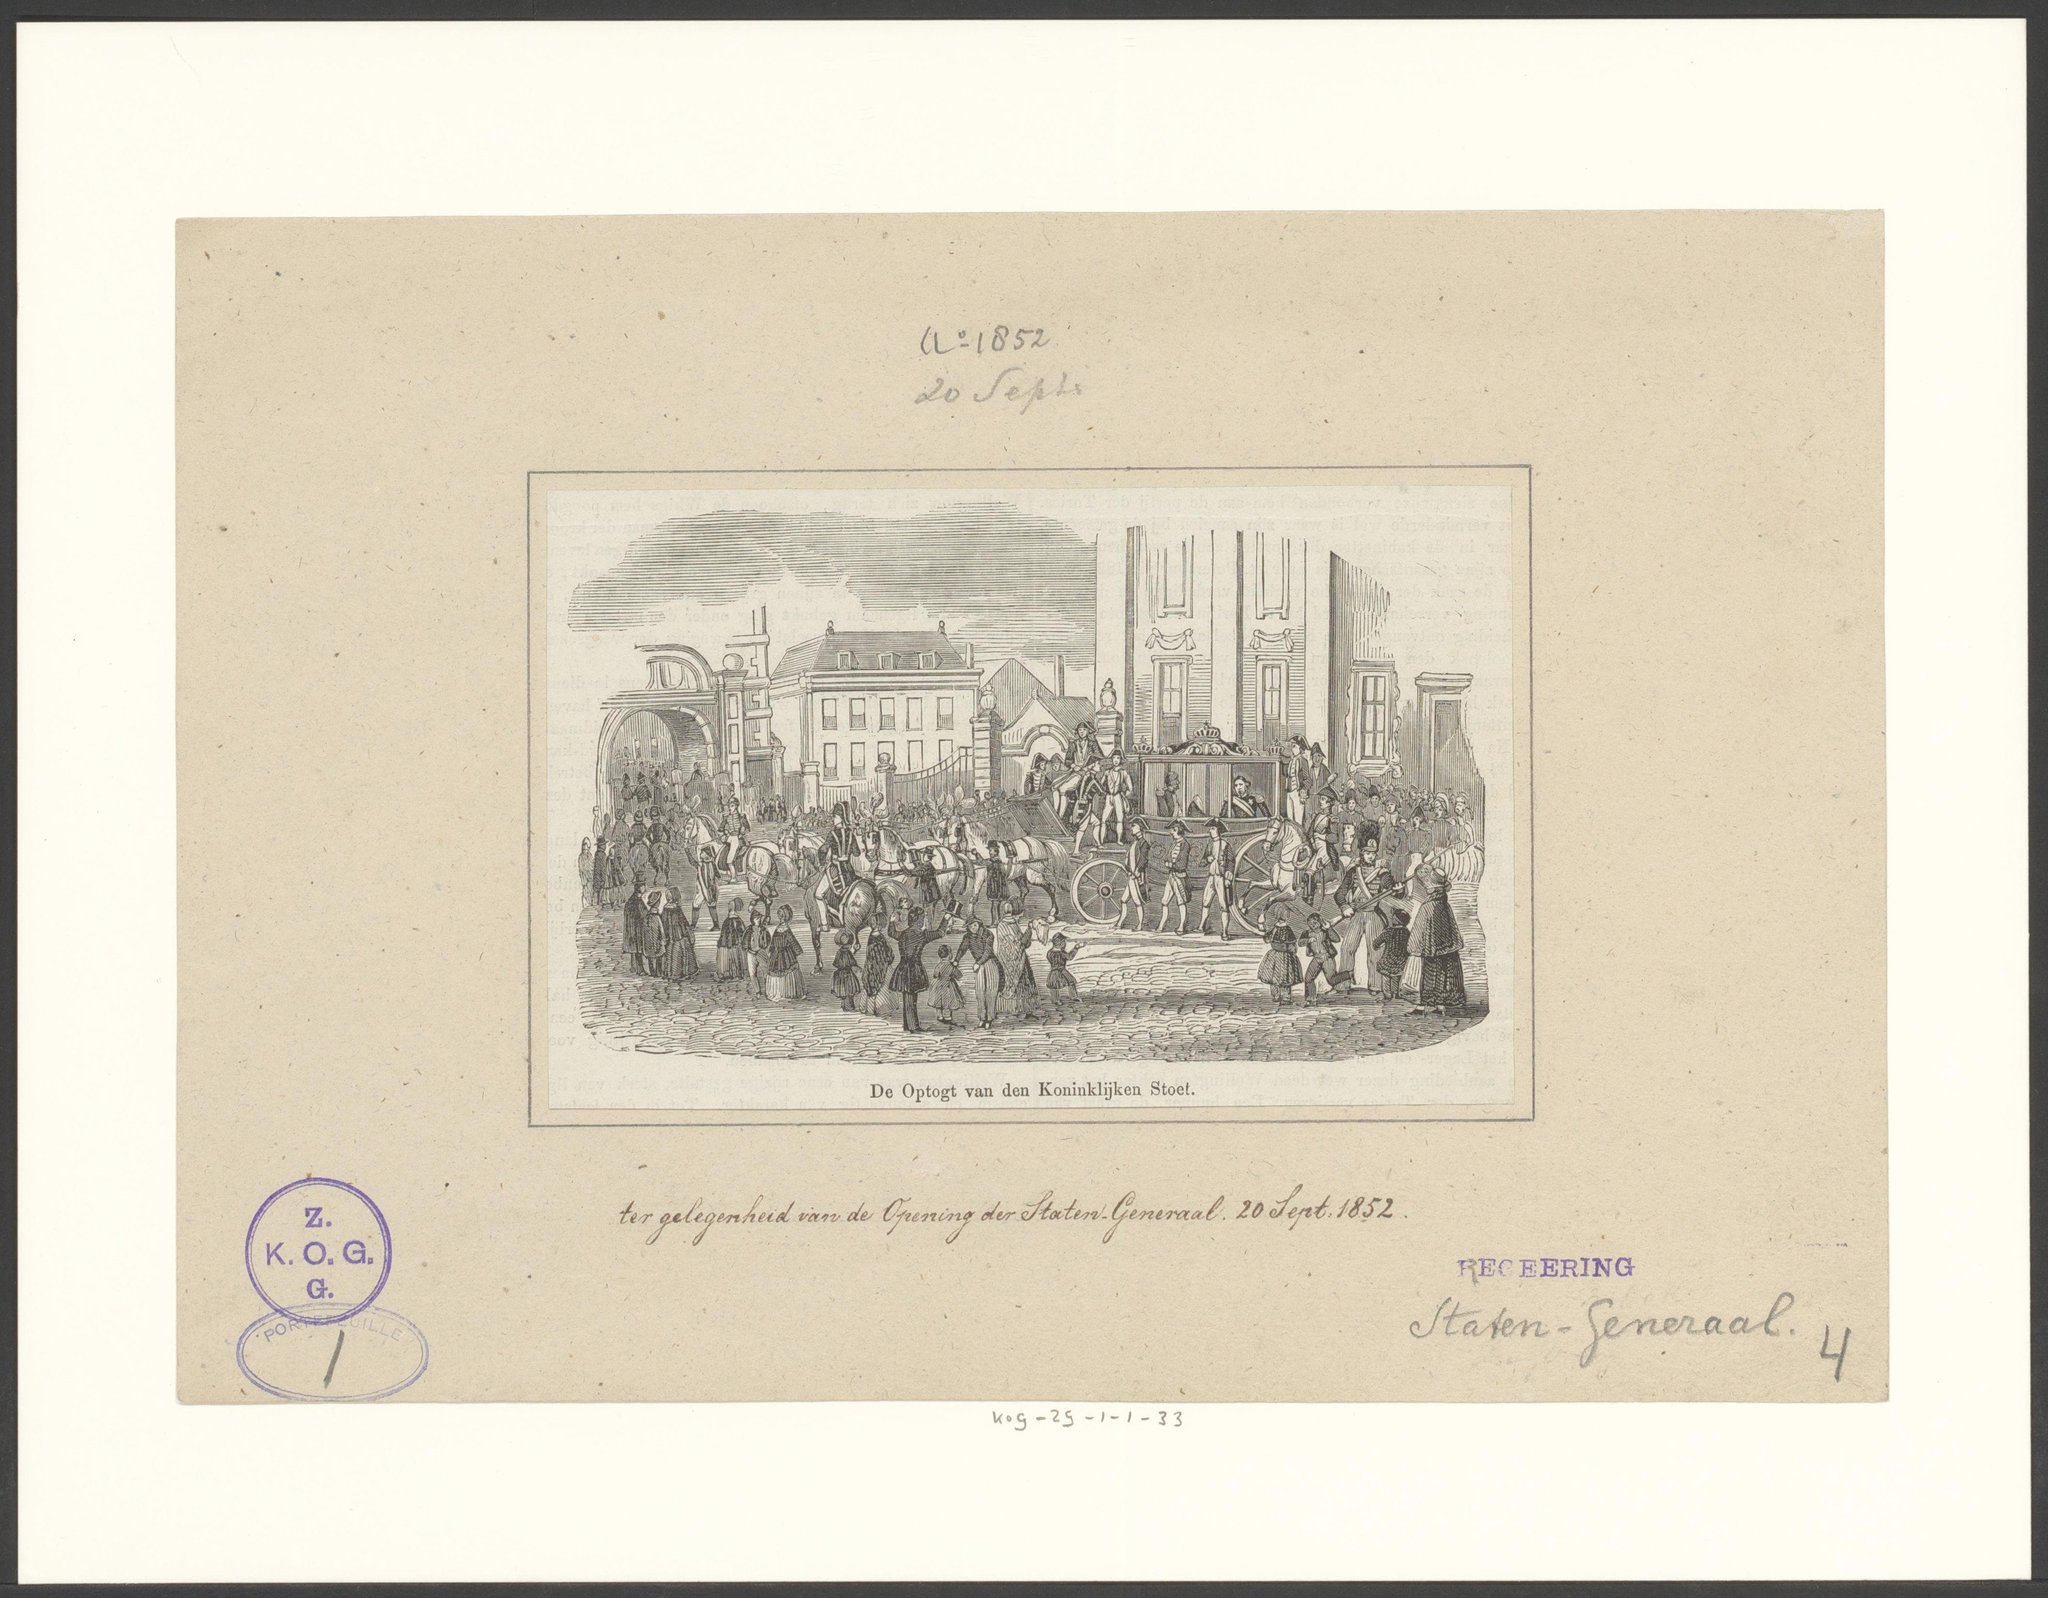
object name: print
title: Optocht bij de opening van de Staten-Generaal, 1852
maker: Anonymous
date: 1852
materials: paper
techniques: engraving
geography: netherlands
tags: willem iii (koning der nederlanden), voting place, polling station, the hague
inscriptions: collector's mark, collector's mark: Lugt 1641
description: Optocht met de koets door Den Haag, bij de opening van de zitting van de Staten-Generaal, 20 september 1852. Bedrukt met tekst op de verso. Onderwerpsrubrieken binnen de Atlas Zeden en Gewoonten: Regeering, Staten-Generaal.